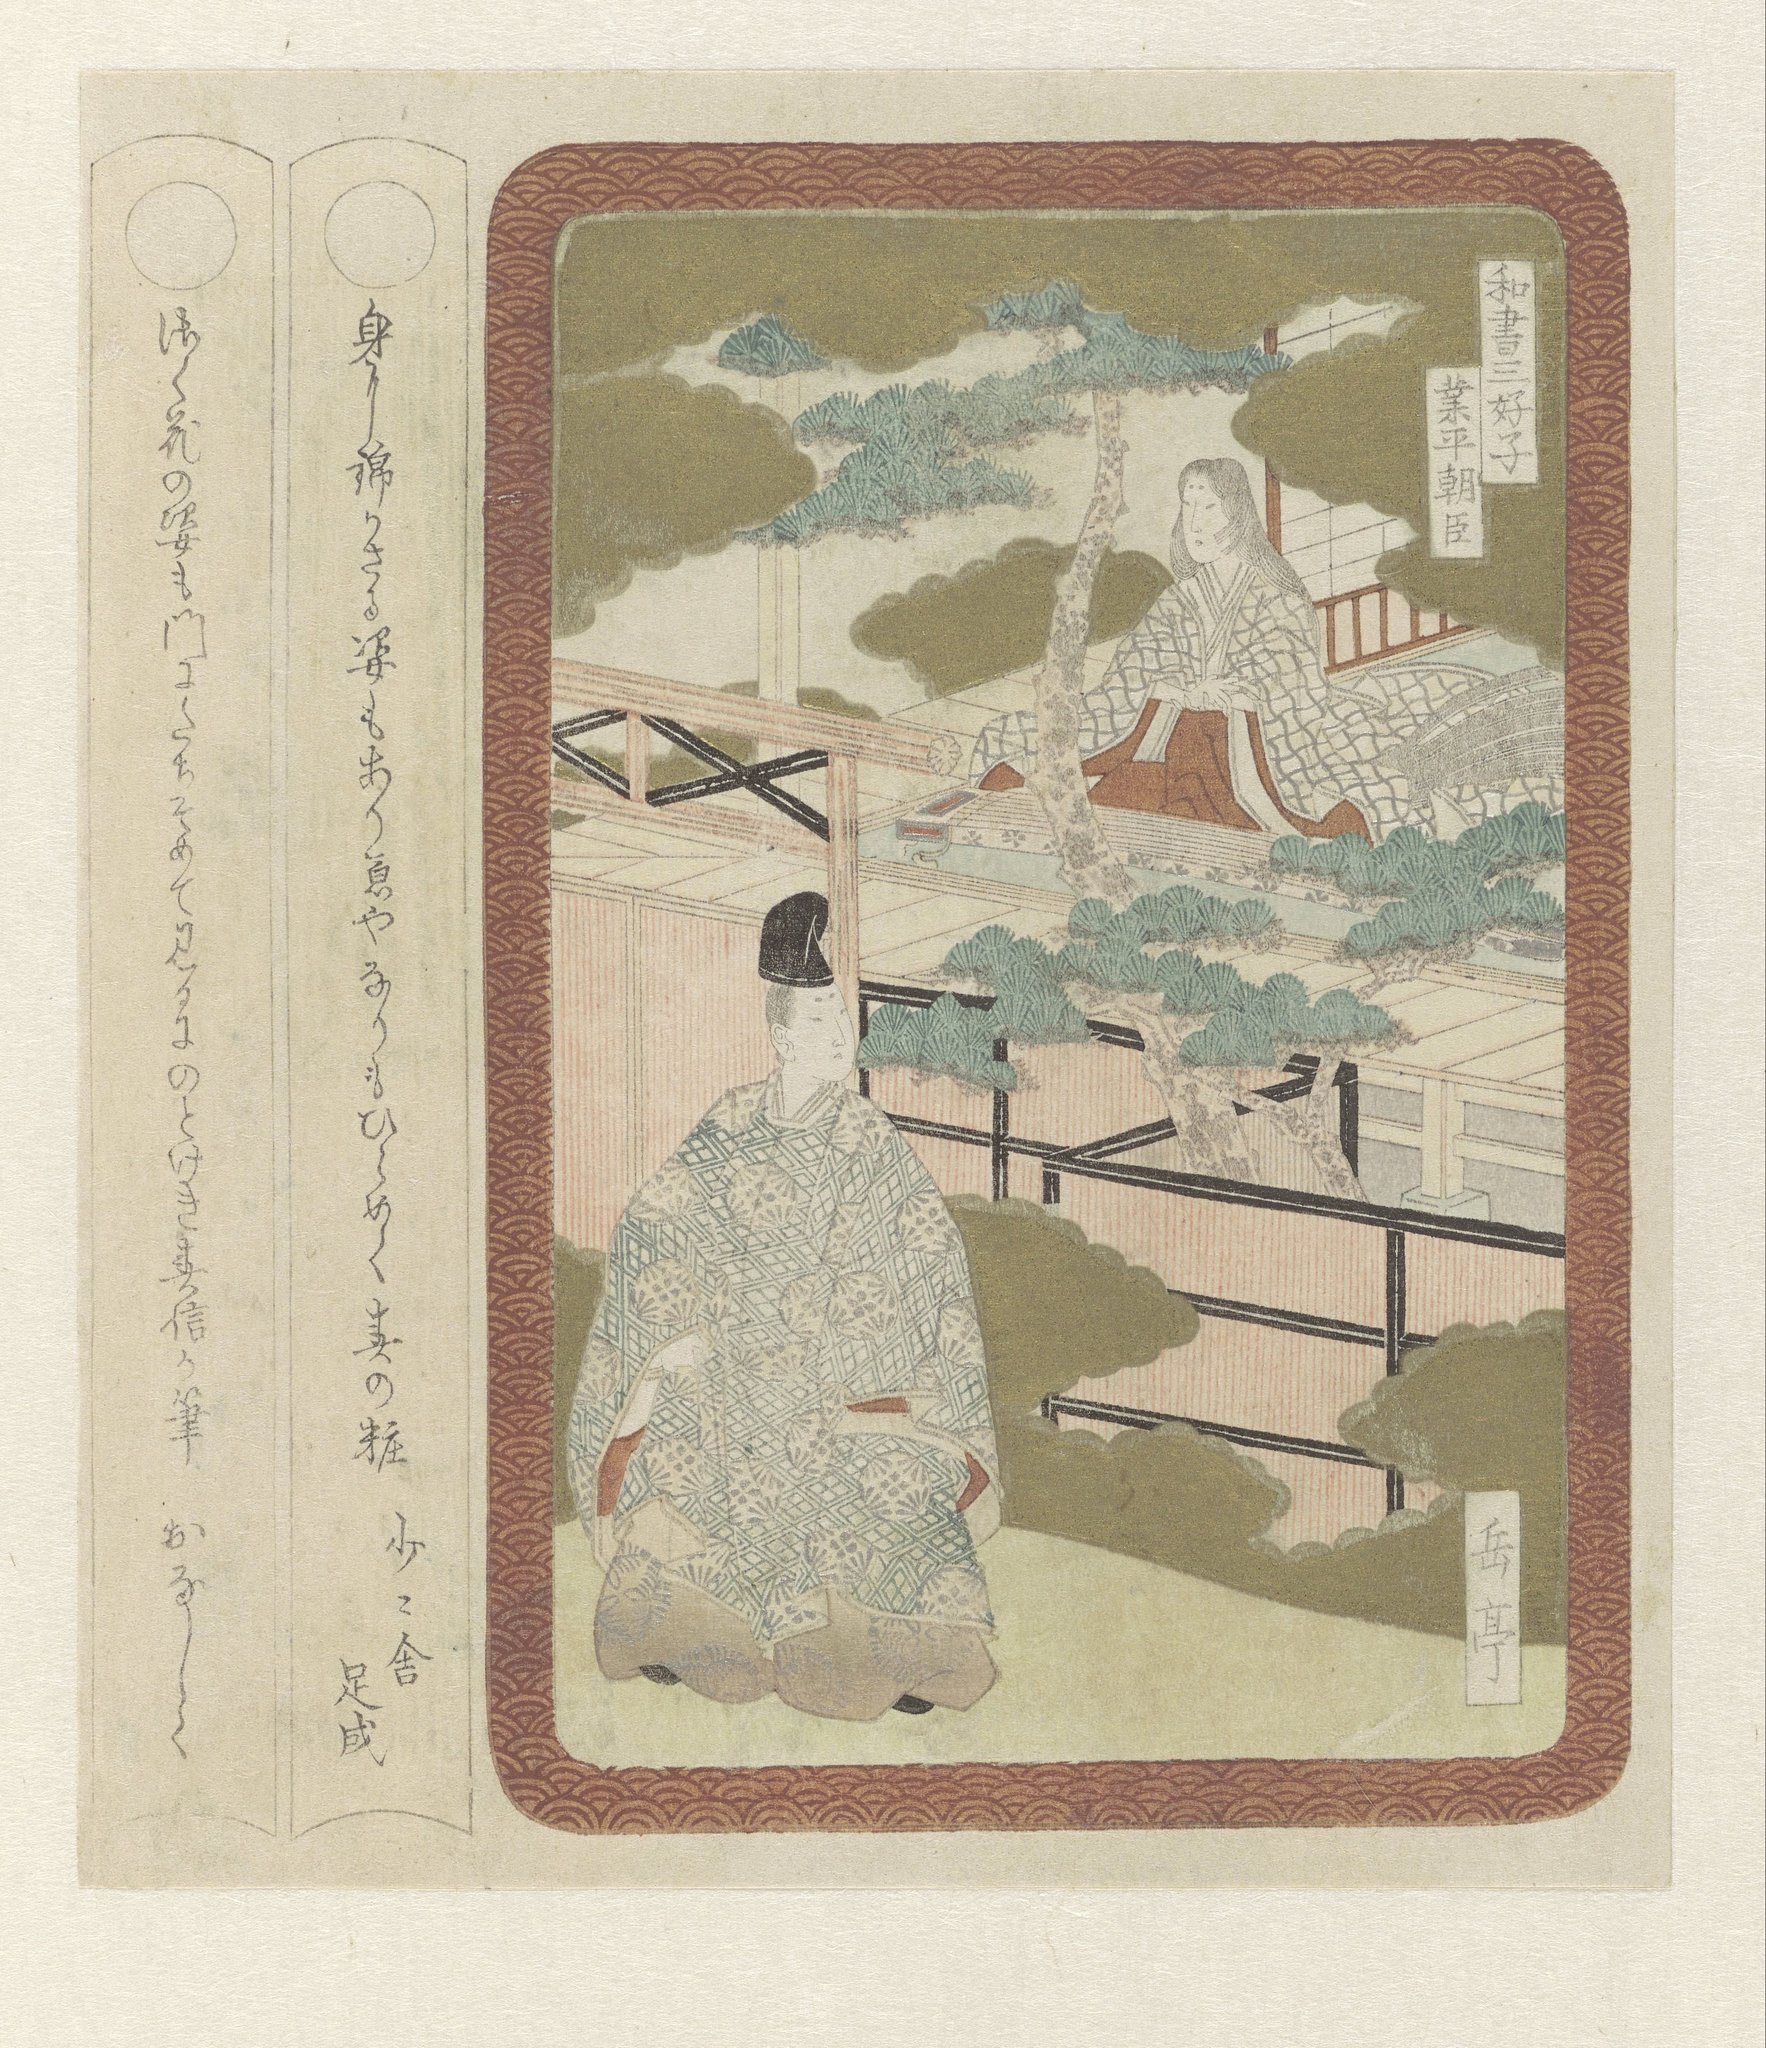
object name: surimono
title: Three gentleman of Japanese literature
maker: yashima gakutei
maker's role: print maker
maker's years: 1786-1868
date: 1819-1820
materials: paper, pigment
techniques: blind stamped, woodcut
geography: japan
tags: listening to music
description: Een surimono is een luxe uitgevoerde prent waarop beeld met één of meerdere gedichten gecombineerd is. Bij het drukken van een surimono werd vaak gebruik gemaakt van dikker papier, blinddruk en metaal pigmenten, zoals koper- en zilverpoeder. De prenten werden vaak in opdracht van dichters gemaakt en als exclusief geschenk aan vrienden en relaties gegeven.